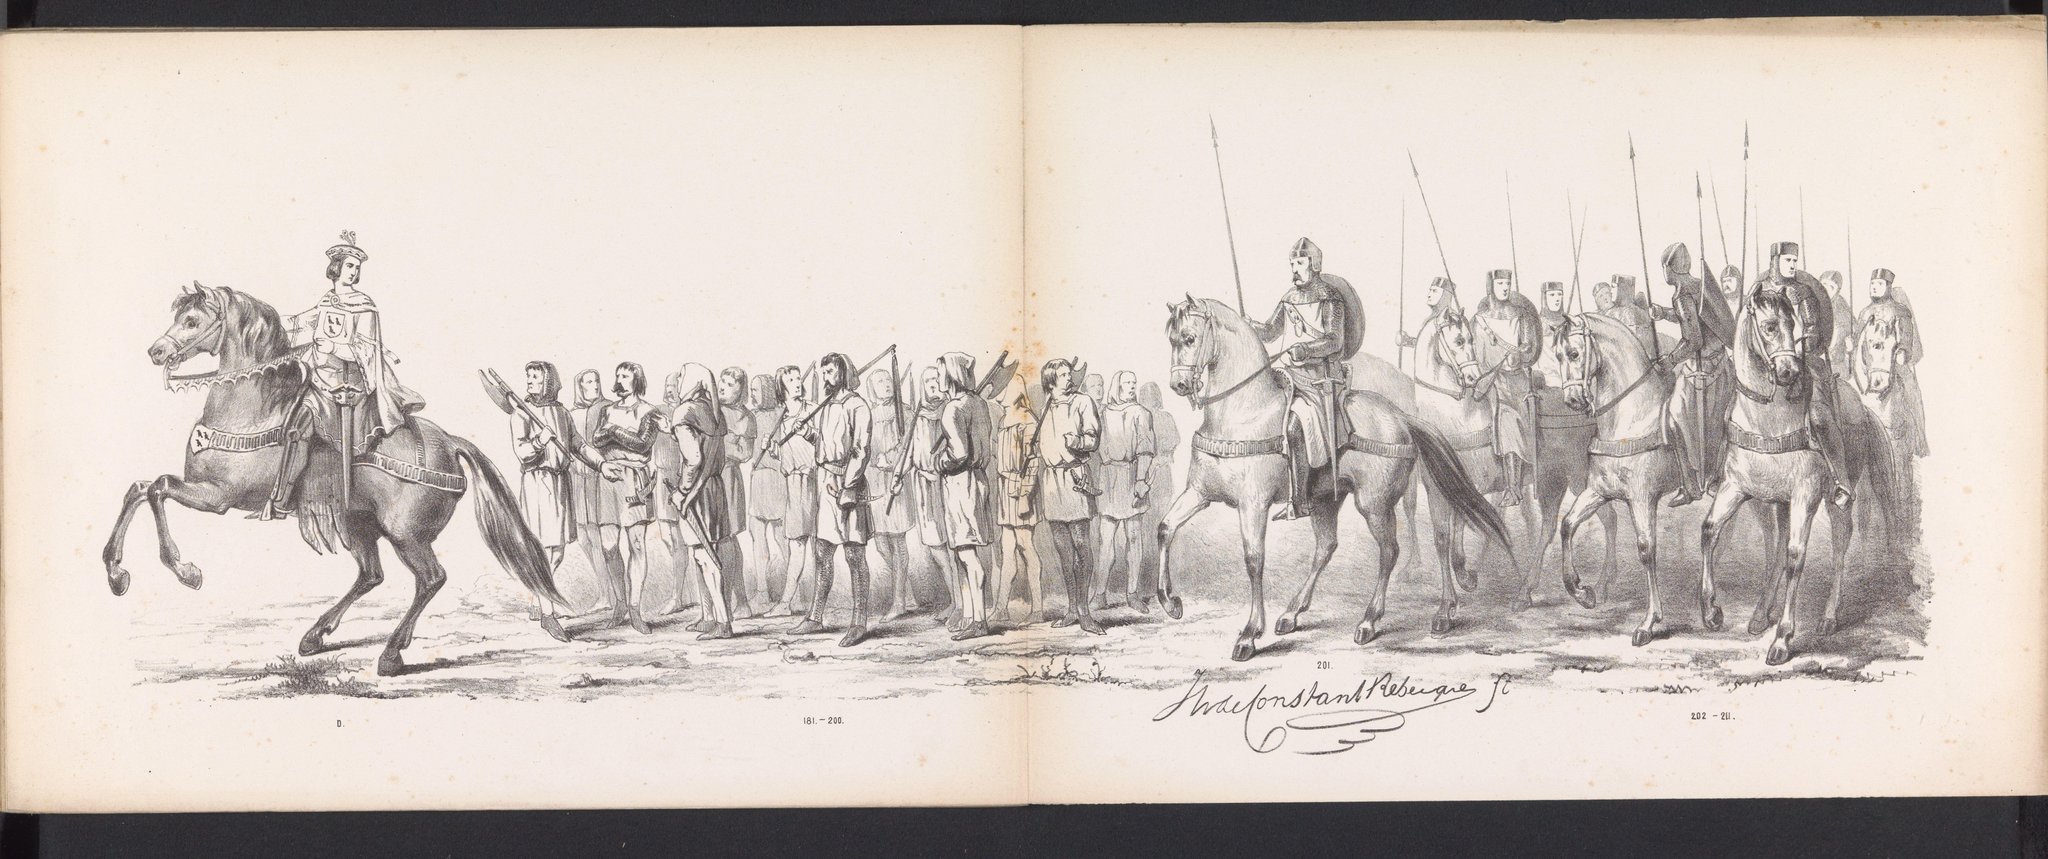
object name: print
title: Maskerade van de Leidse studenten, 1865 (plaat 15)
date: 1865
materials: paper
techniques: lithograph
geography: netherlands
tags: students' pageant, costumes used in pageants, leiden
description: Historische gekostumeerde optocht van de studenten van de Leidse Hogeschool gehouden op 6 juni 1865 ter gelegenheid van het 290-jarig bestaan van de Hogeschool. De optocht verbeeldt de intocht van de Hollanders binnen Zierikzee op 12 augustus 1304. Vijftiende plaat met de groepen genummerd 181-211. Onderdeel van de serie van 16 aaneen geplakte bladen.